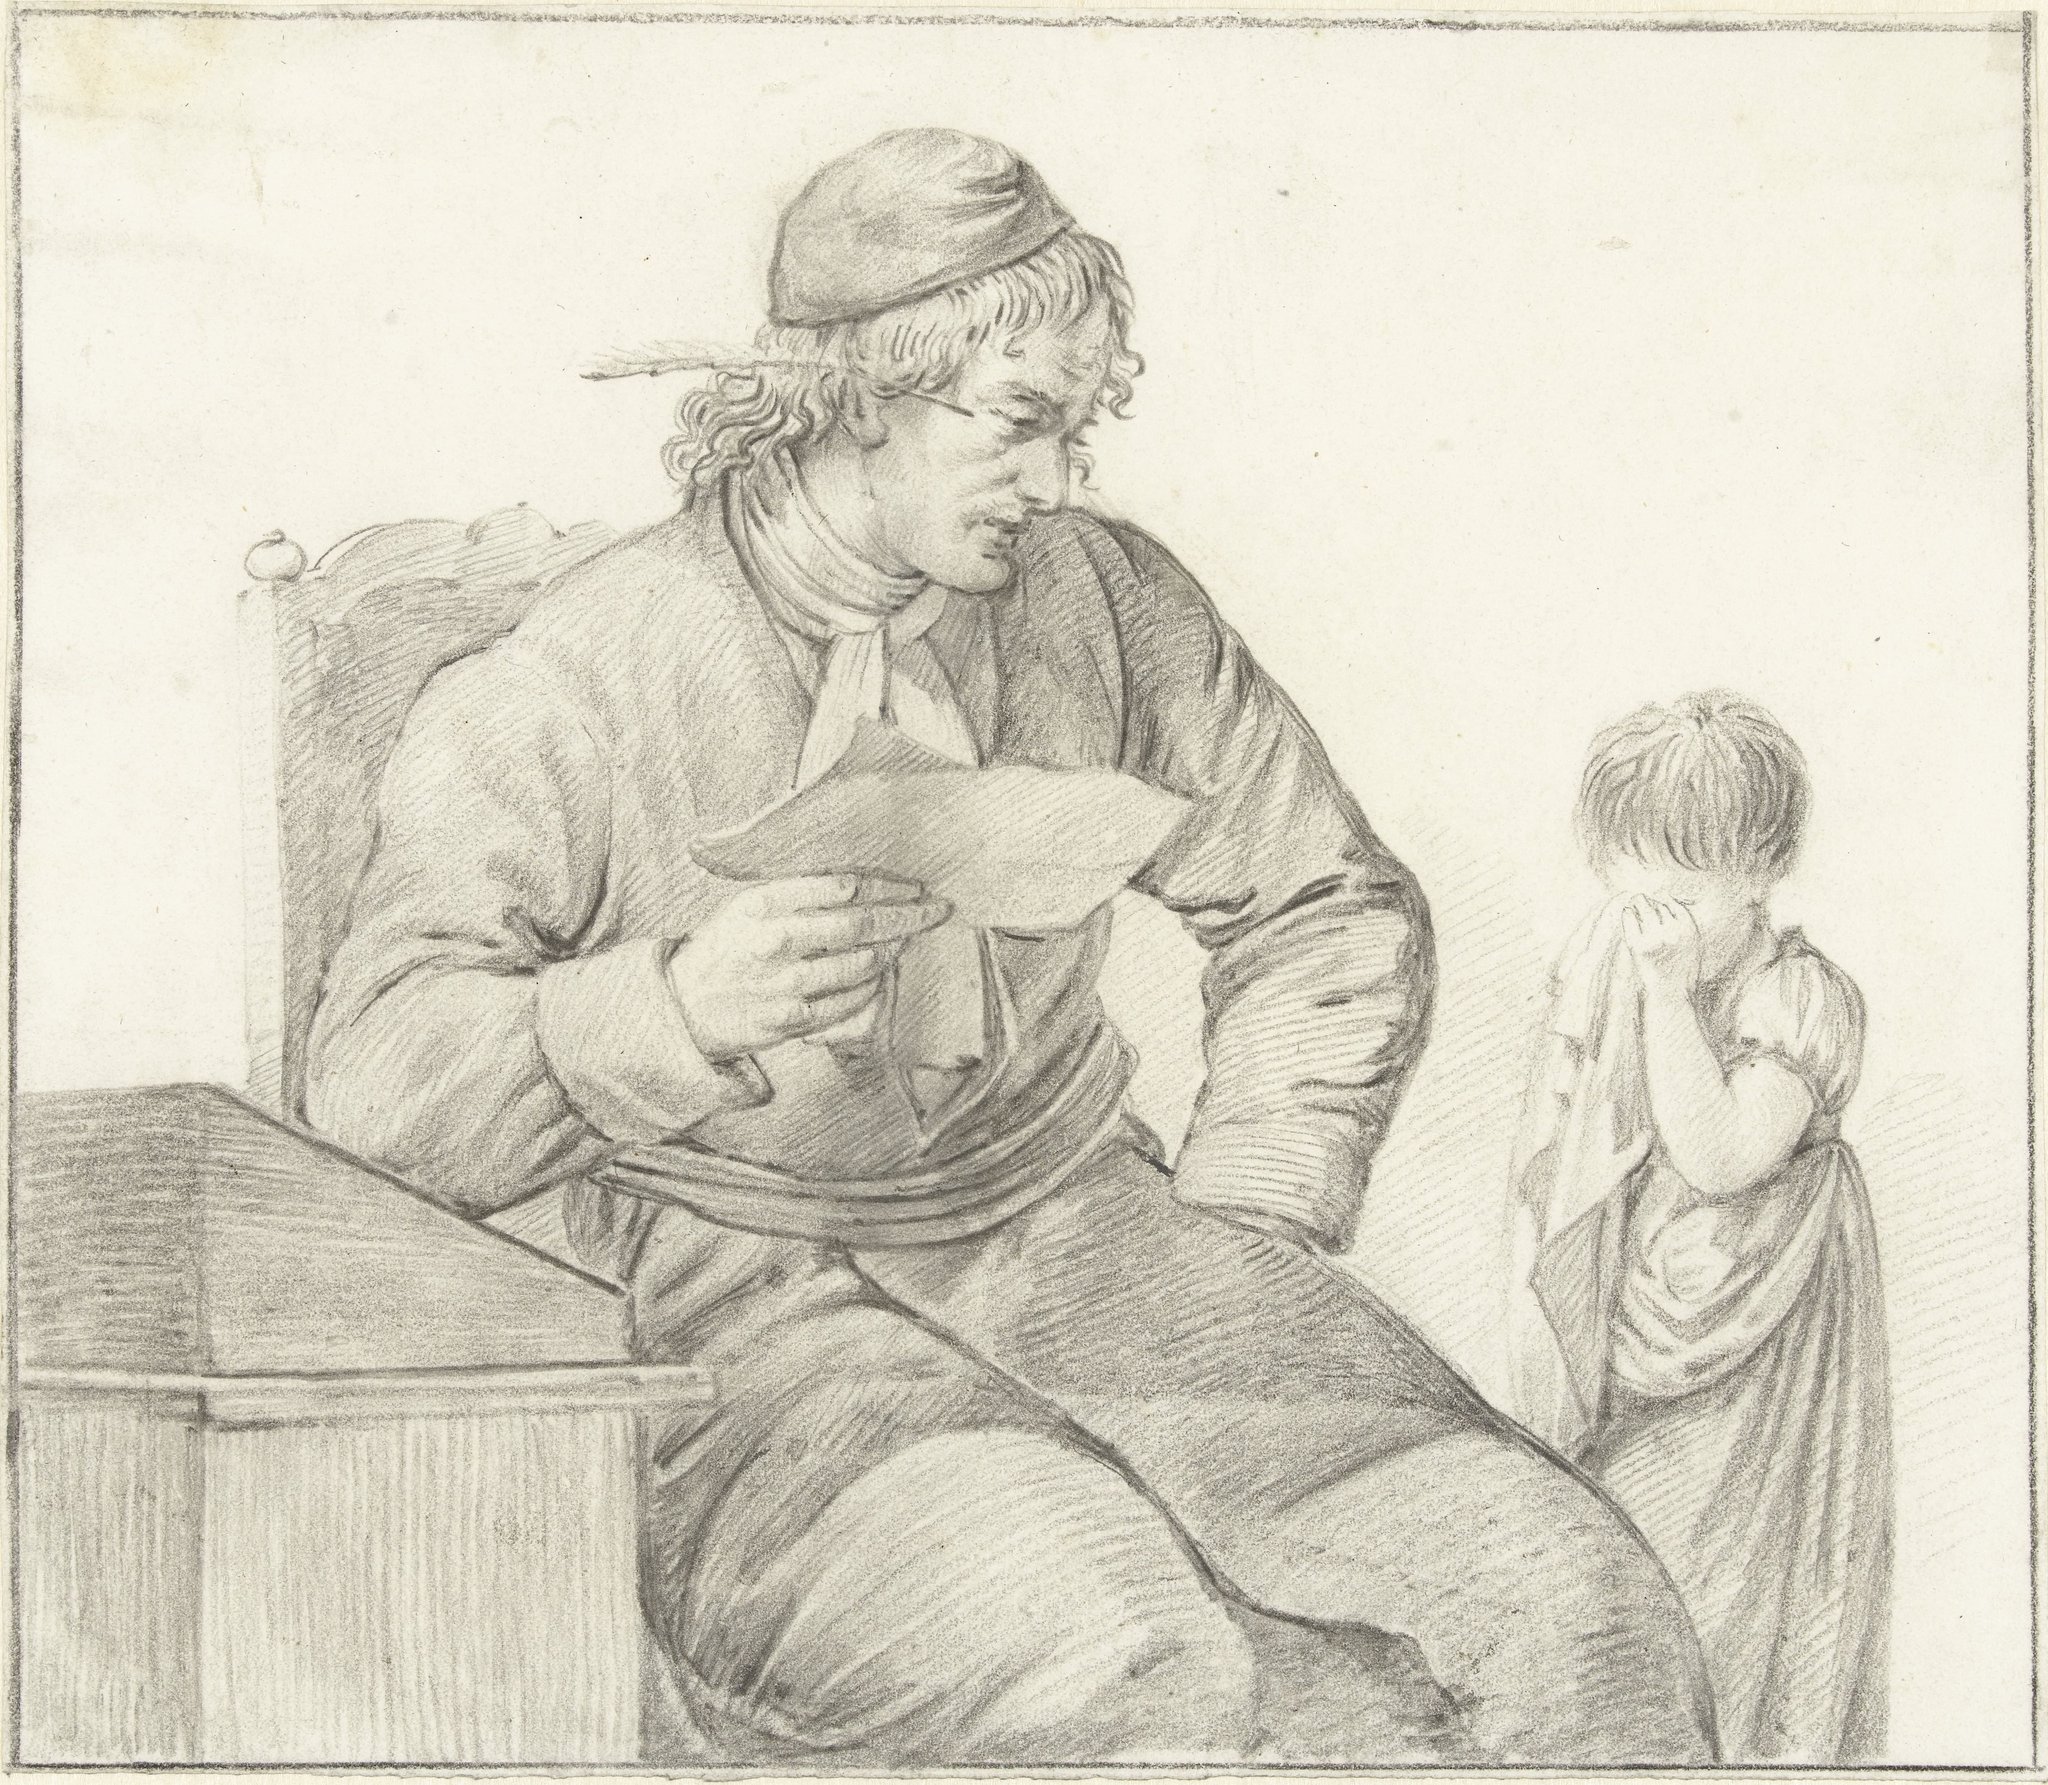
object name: drawing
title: Schoolmeester berispt een klein meisje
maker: pieter pietersz. barbiers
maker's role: draughtsman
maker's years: 1749-1842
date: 1759-1842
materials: chalk, paper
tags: teacher and pupil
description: Schoolmeester, zittend bij een lessenaar, berispt een klein meisje, dat huilend voor hem staat.